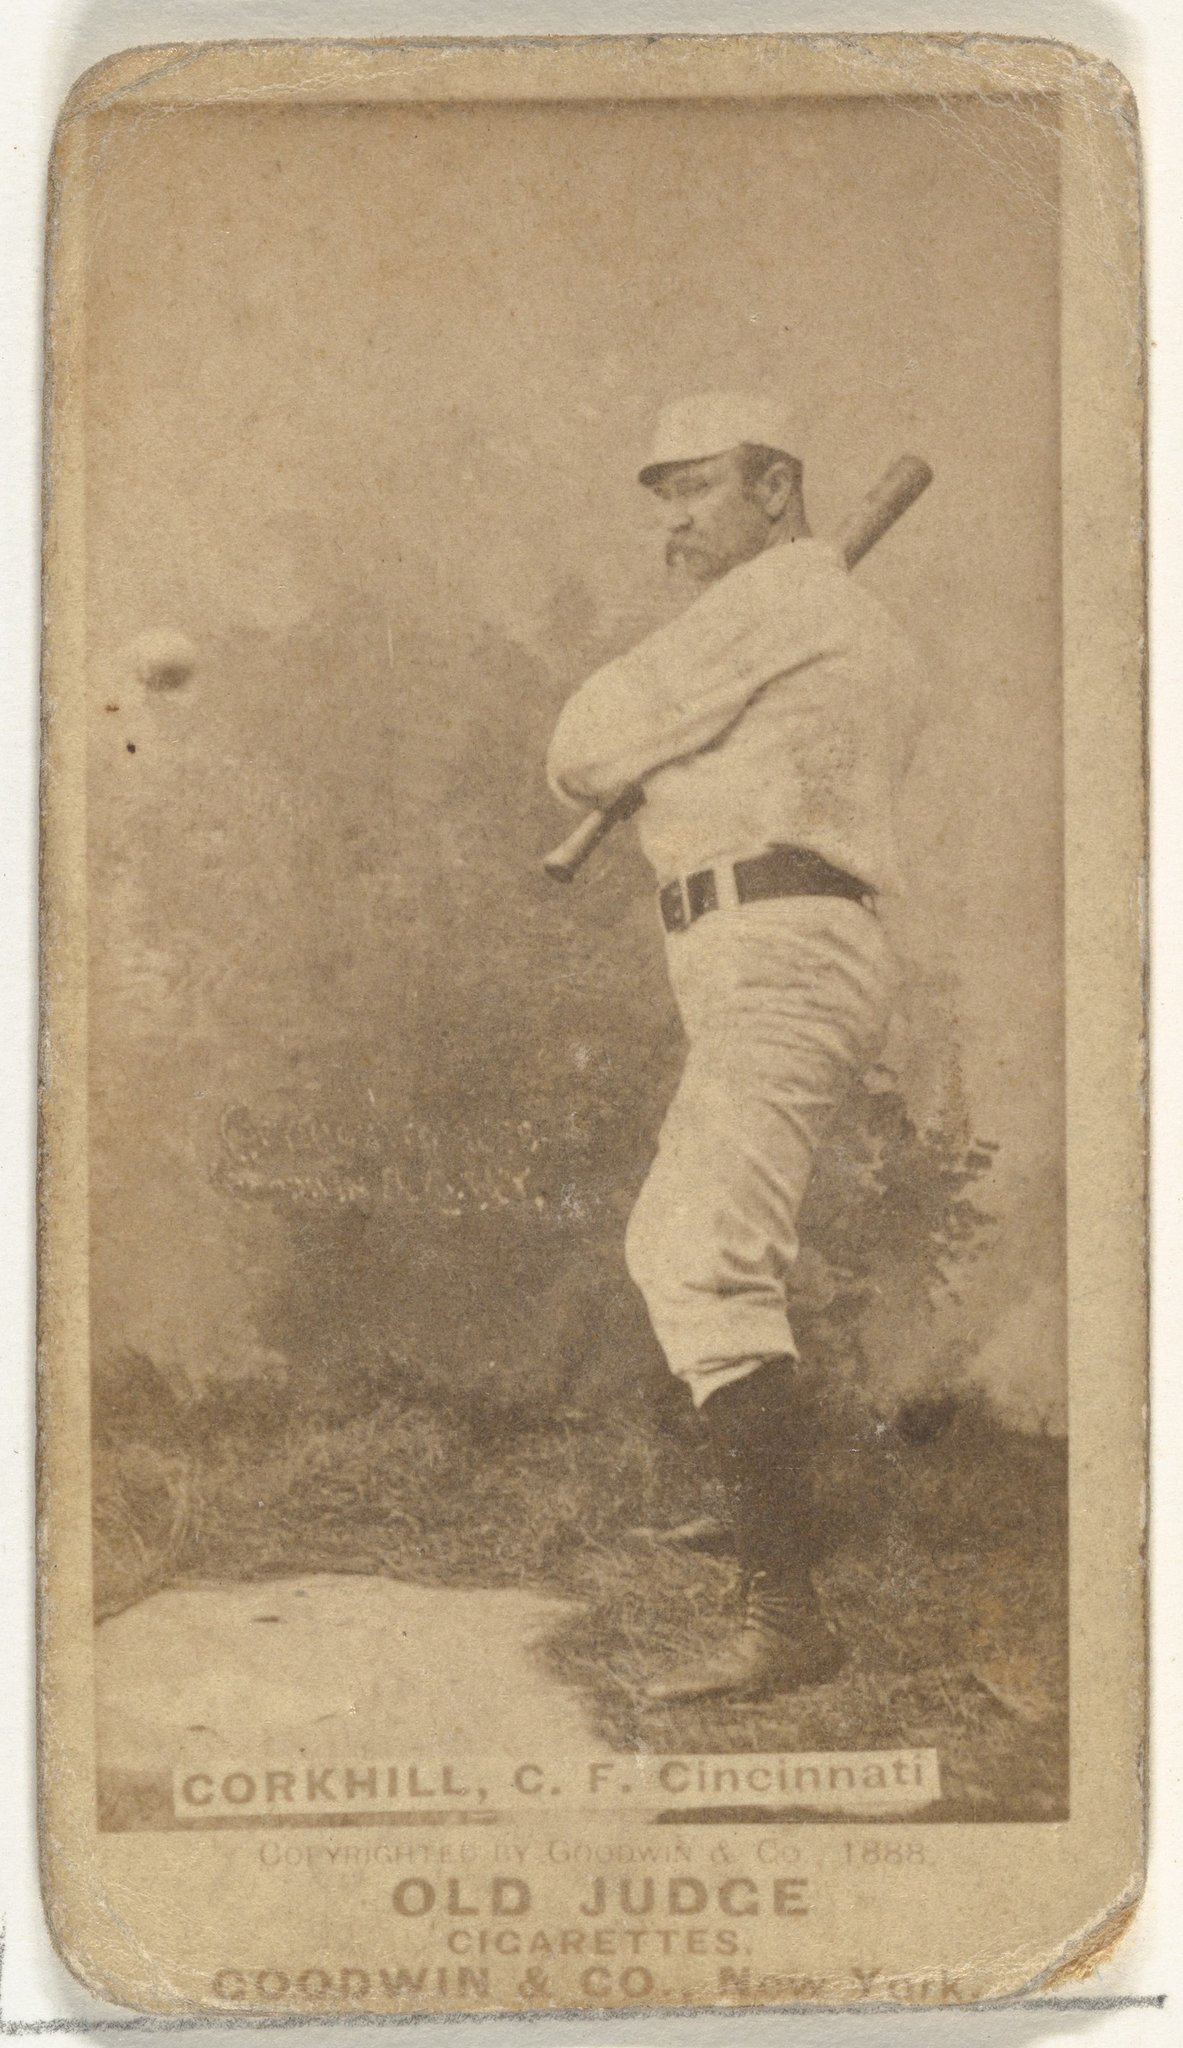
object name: baseball card, photograph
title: John Stewart "Pop" Corkhill, Center Field, Cincinnati, from the Old Judge series (N172) for Old Judge Cigarettes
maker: goodwin & company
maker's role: publisher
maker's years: 1850-1950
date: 1888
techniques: albumen silver print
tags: men,portraits,baseball,athletes